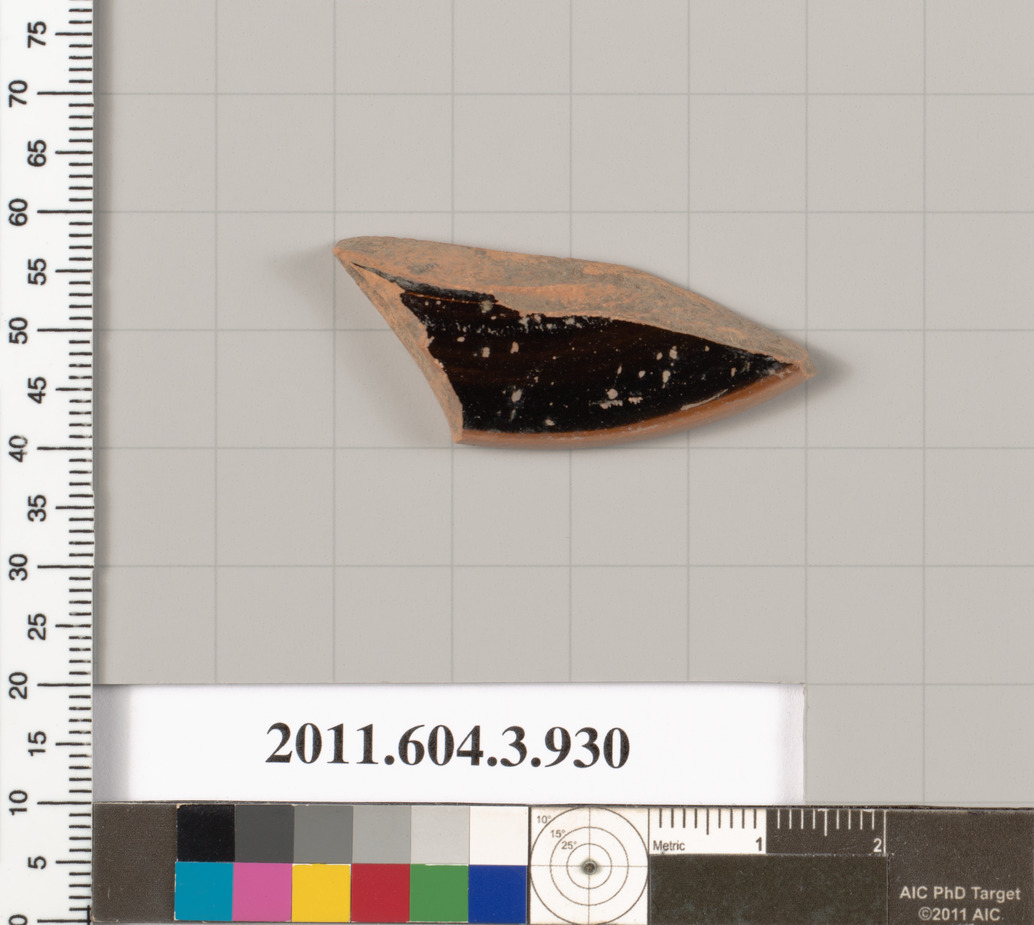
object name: lekythos fragment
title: Terracotta fragment of a lekythos (oil flask)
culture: greek, attic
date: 600-401 BCE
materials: terracotta